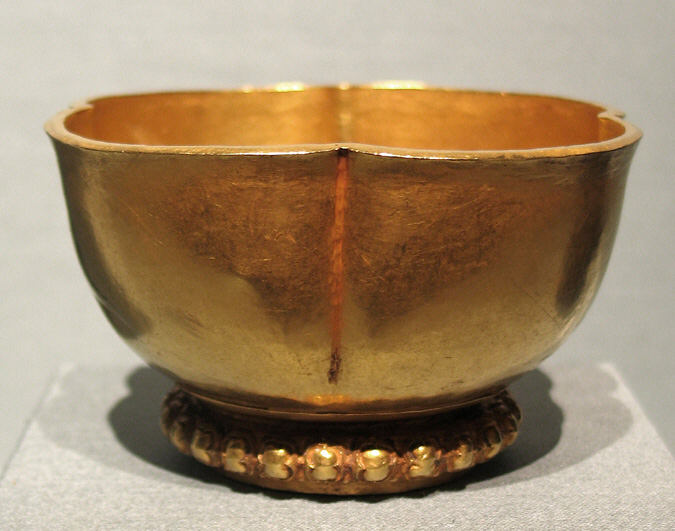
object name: bowl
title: Lobed Bowl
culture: indonesian, javanese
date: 701-833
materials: gold, silver